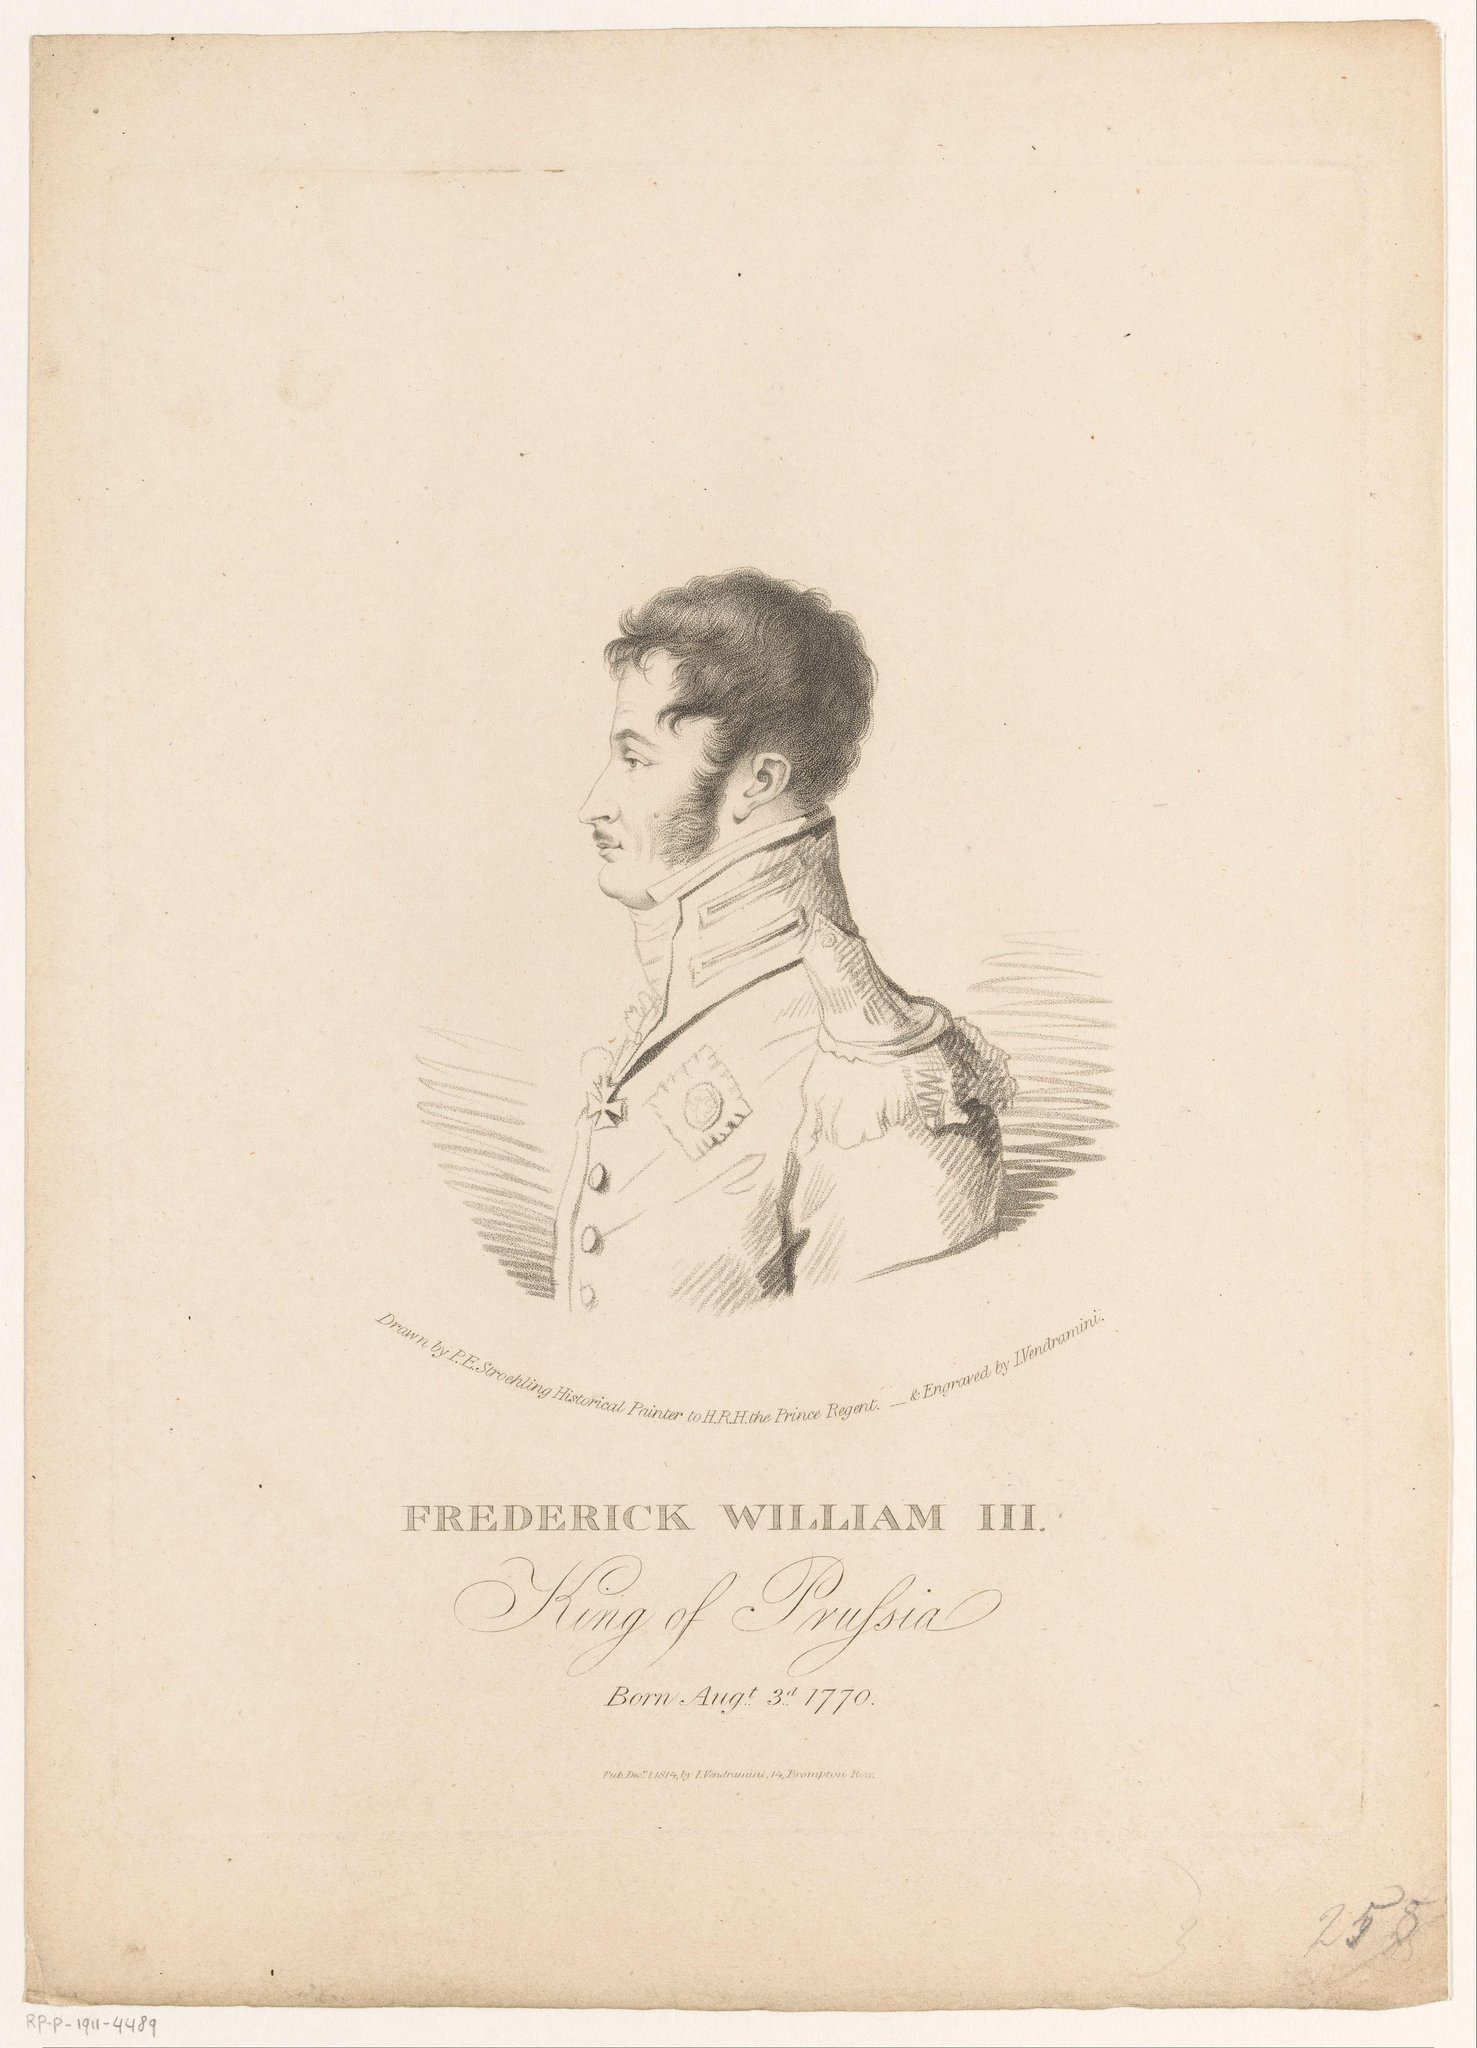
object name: print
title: Portret van Frederik Willem III, koning van Pruisen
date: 1814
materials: paper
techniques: engraving, roulette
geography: london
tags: berlin, frederik willem iii koning van pruisen, historical persons, ruler, sovereign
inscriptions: collector's mark: Lugt 2228